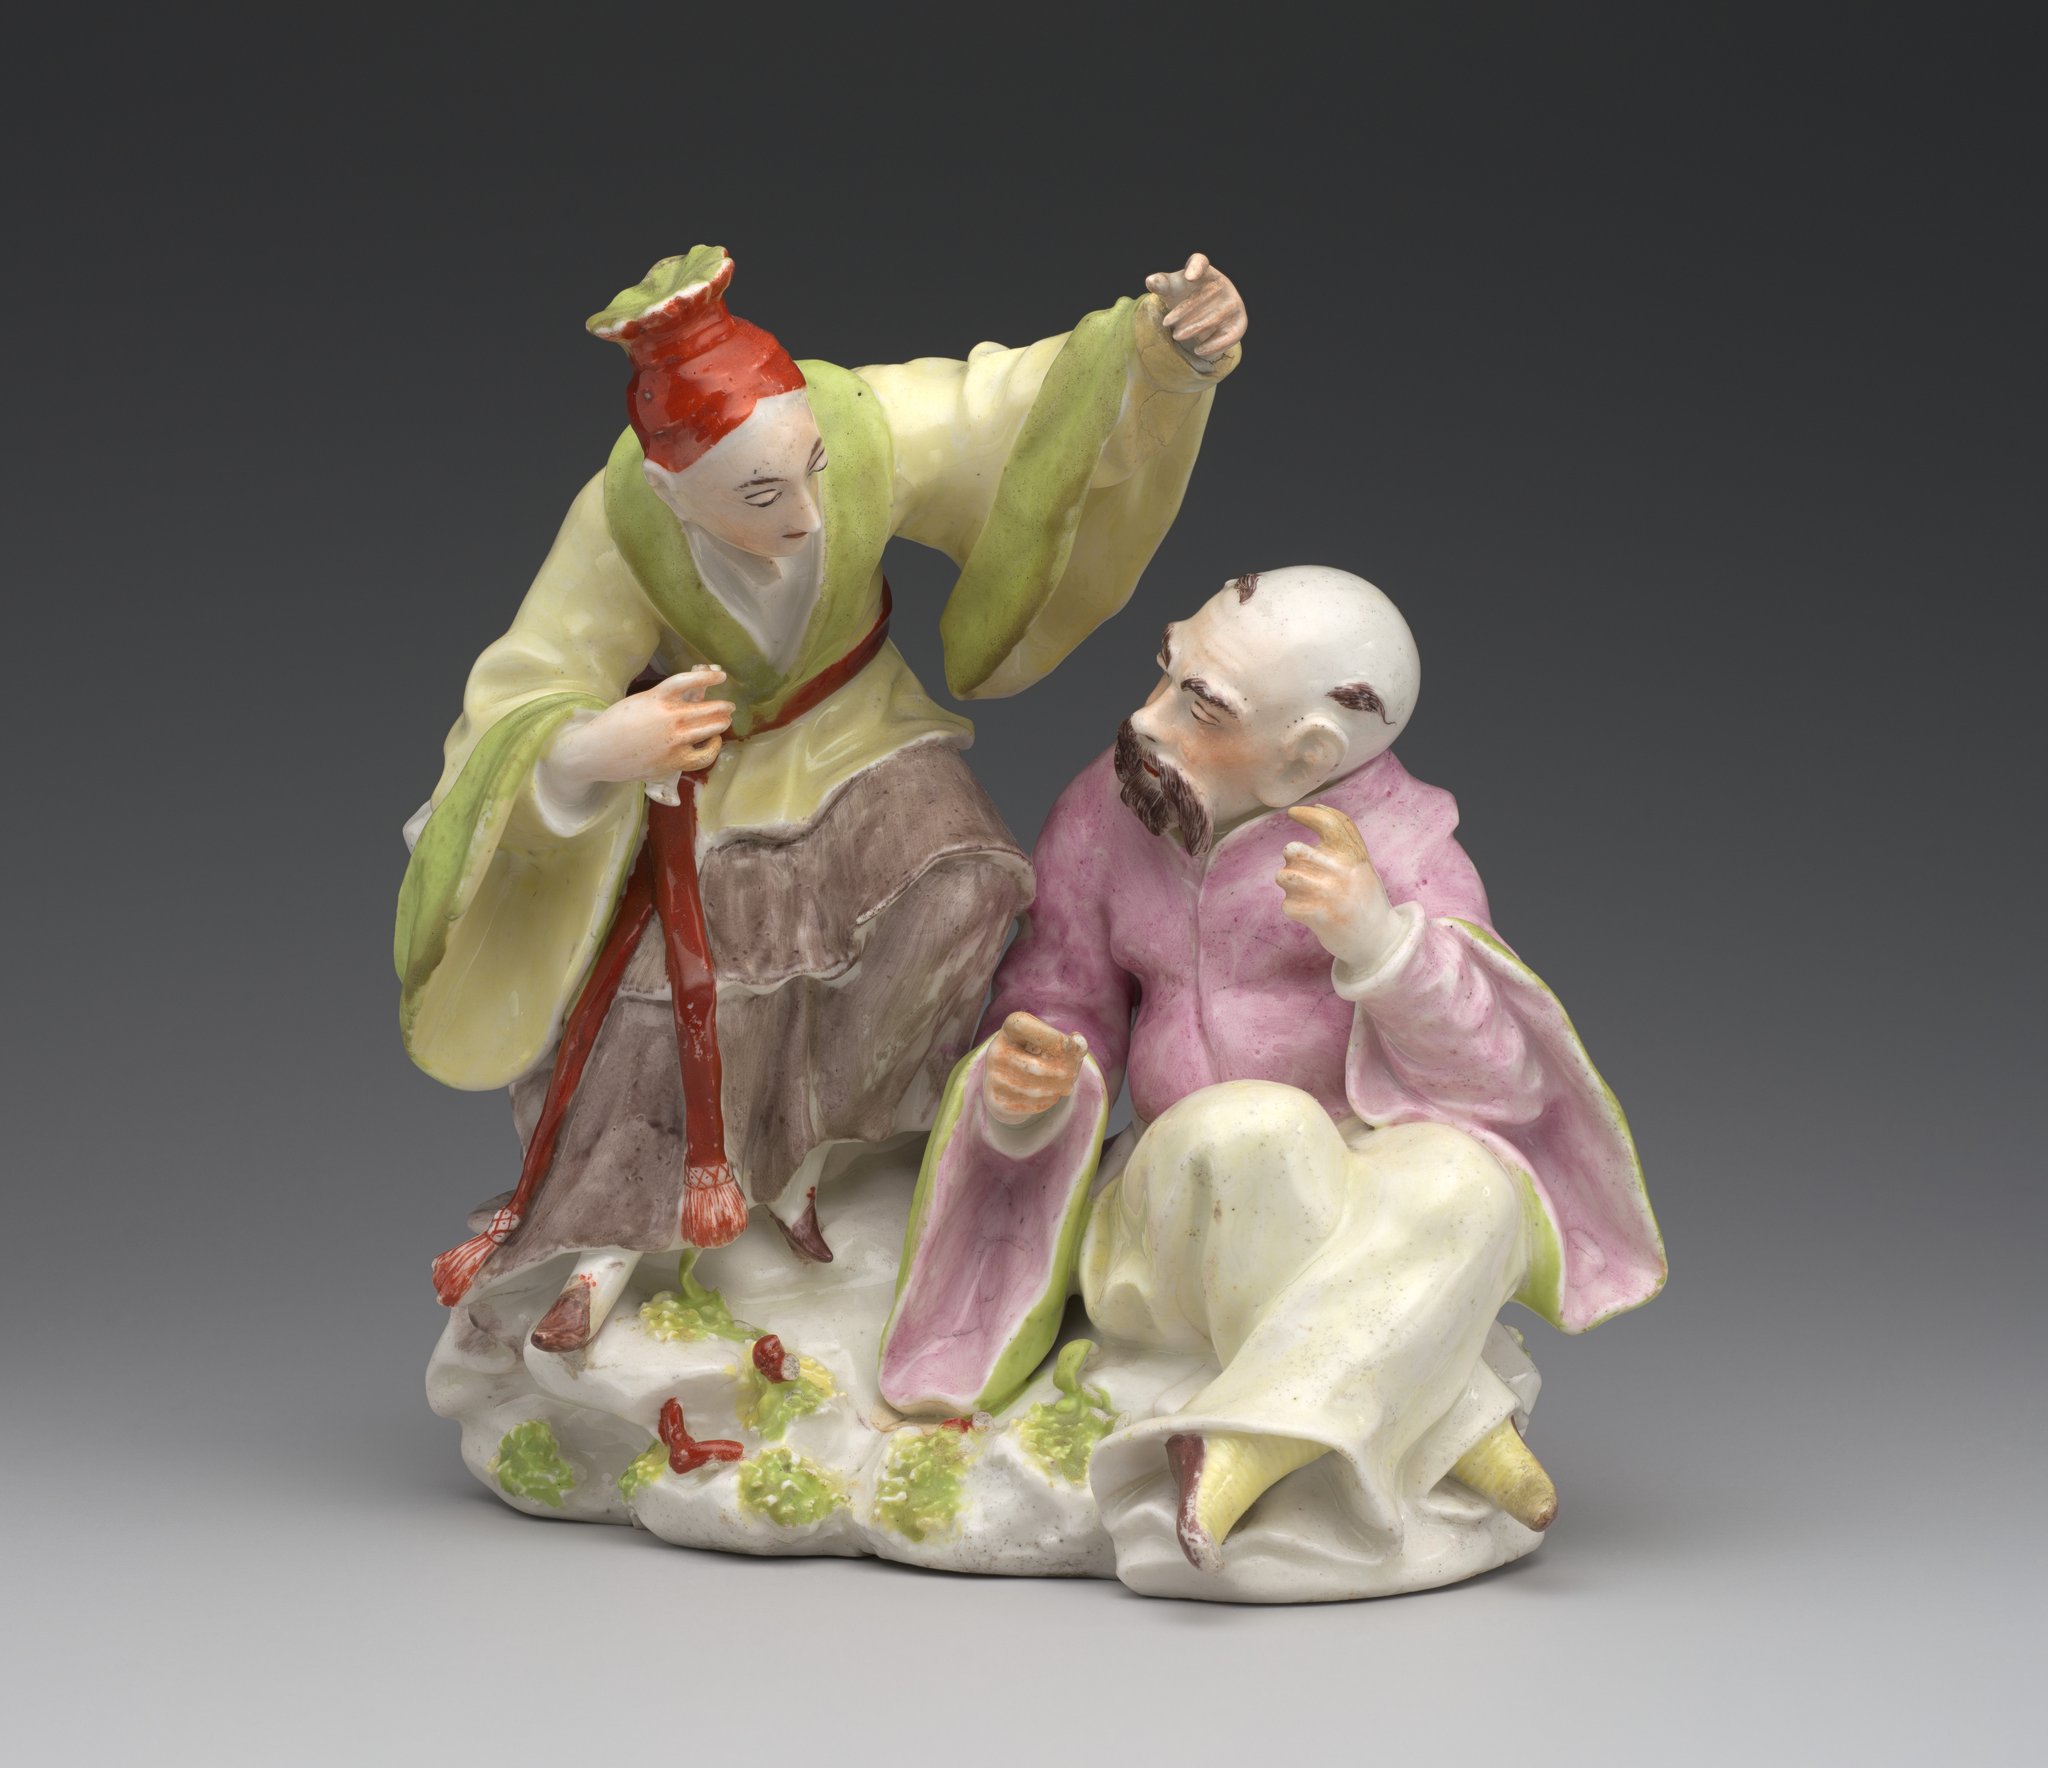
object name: group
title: Chinoiserie group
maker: derby porcelain manufactory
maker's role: factory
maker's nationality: british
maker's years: 1751-1785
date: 1750-1755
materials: soft paste porcelain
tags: chinoiserie,men,women